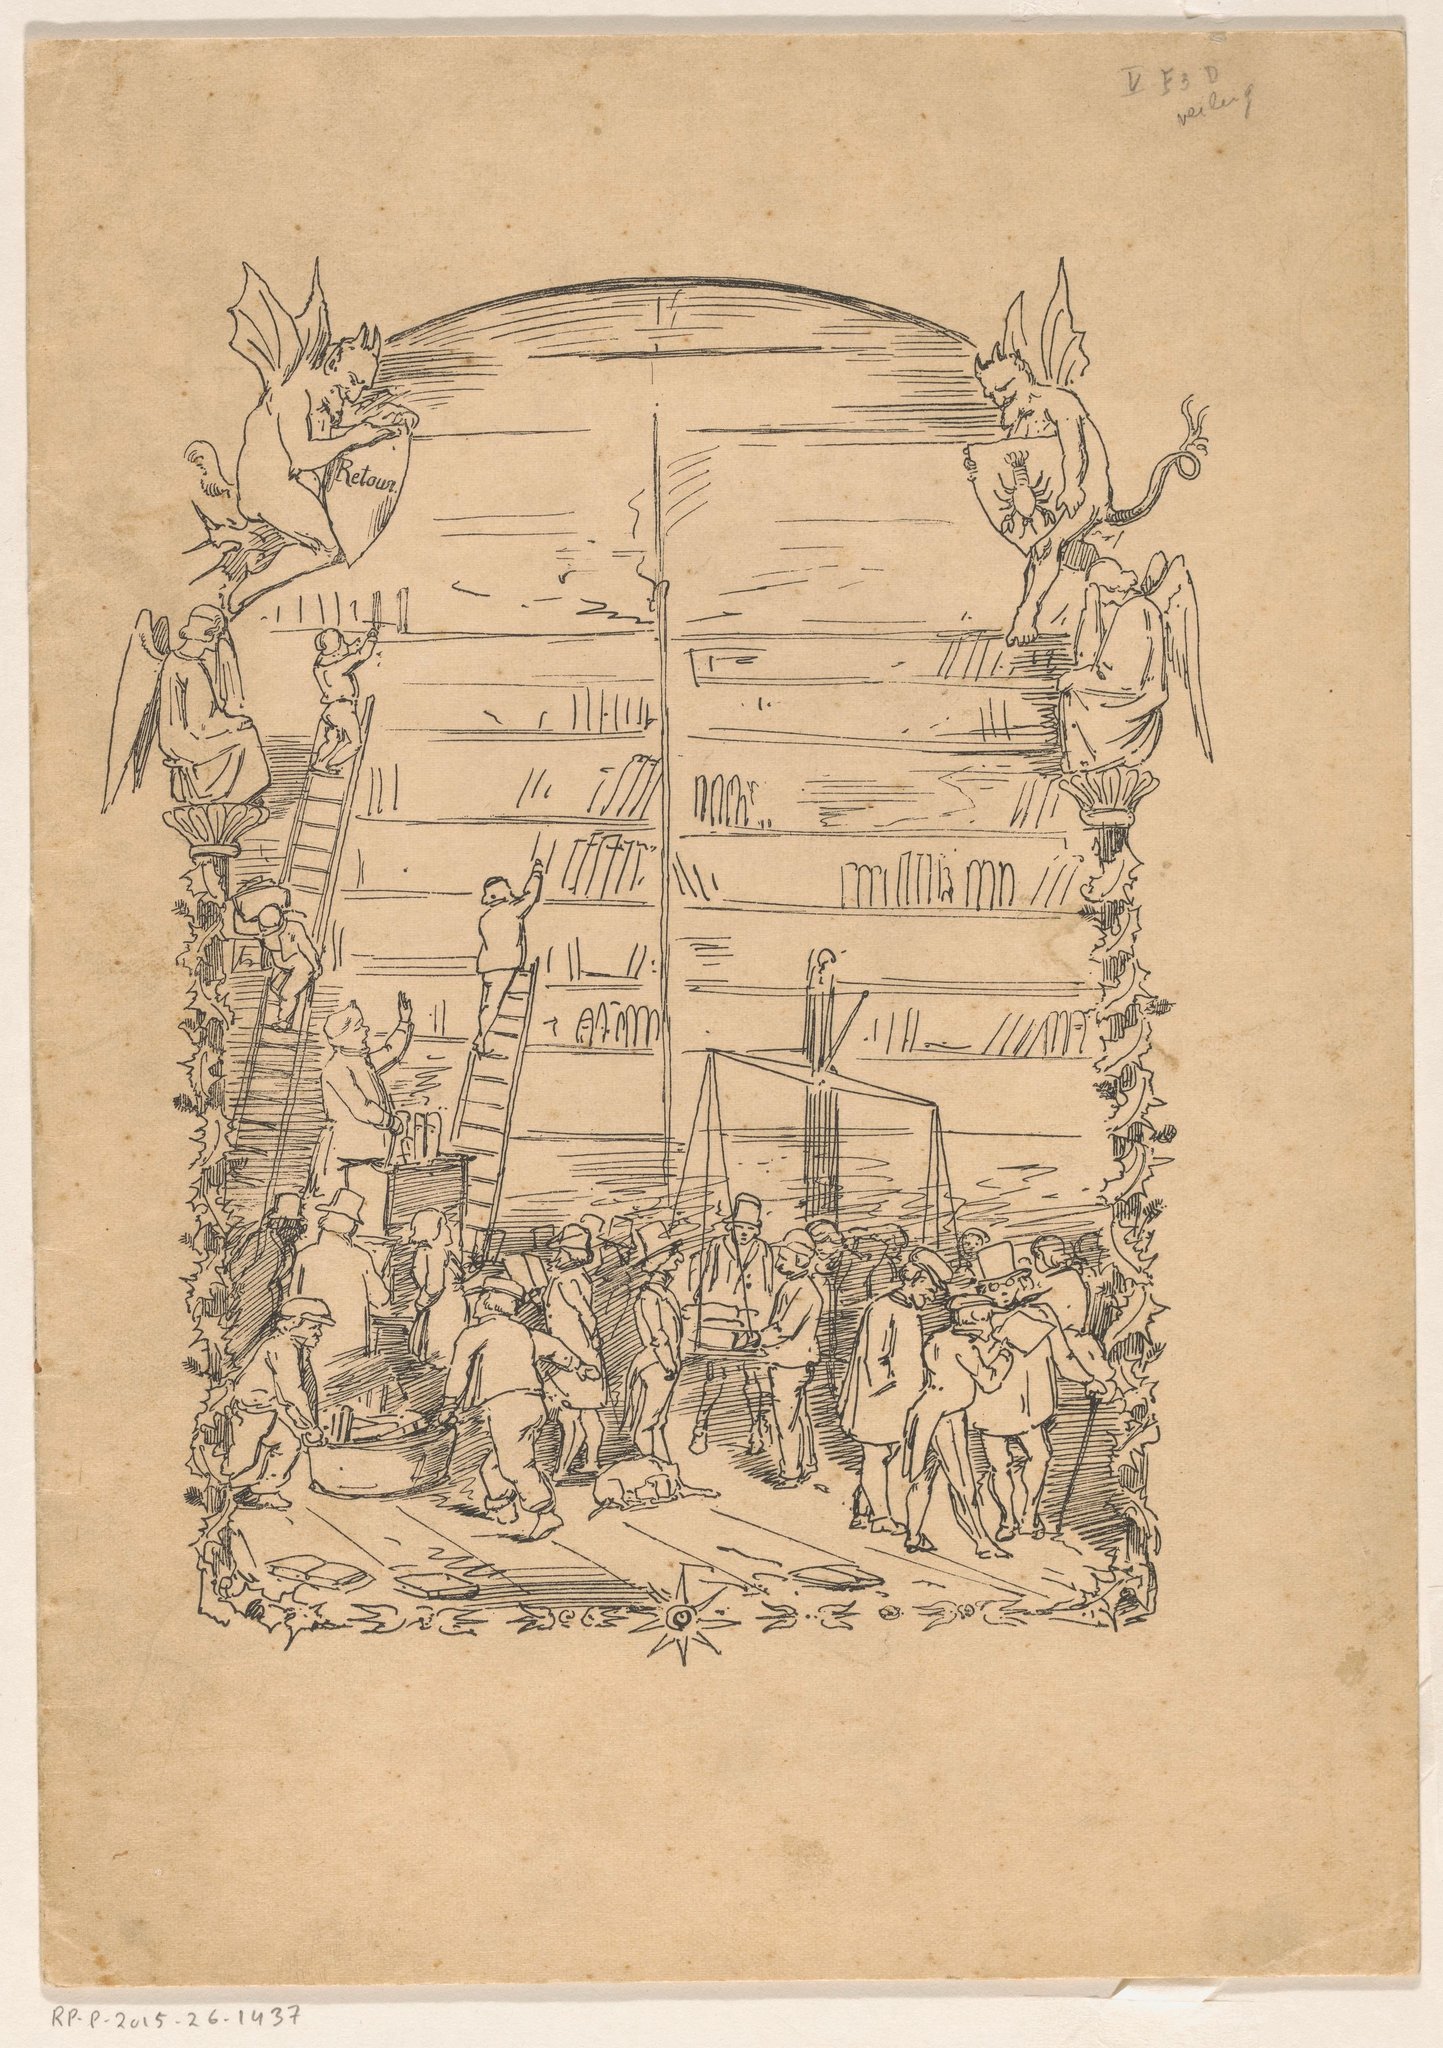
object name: publication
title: Veilingzaal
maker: Anonymous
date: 1935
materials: paper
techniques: lithograph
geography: leipzig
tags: bookshelves, devil(s) and demons, scales, book, angels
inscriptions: collector's mark: Lugt 4779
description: Prent op de omslag van: Bernhard von Pleissensbruch [pseudoniem van Bernhard Wendt]. Auktion 1000 "Aus der Sammelkiste eines Vergessenen". Teile der Bibliothek des hervorragenden Schizophrenisten Balduin Sternhafel. Leipzig: Geschäftsstelle des Wirtschaftsverbandes Deutscher und Ausländischer Antiquariatsbuchhändler, 1935. Het betreft een fictieve catalogus met humoristische kavels als de liefdesbrieven van Caesar en Cleopatra, de haarlok van Karel de Kale en lege pagina's afkomstig van Schubert's 'Unvollendete'.